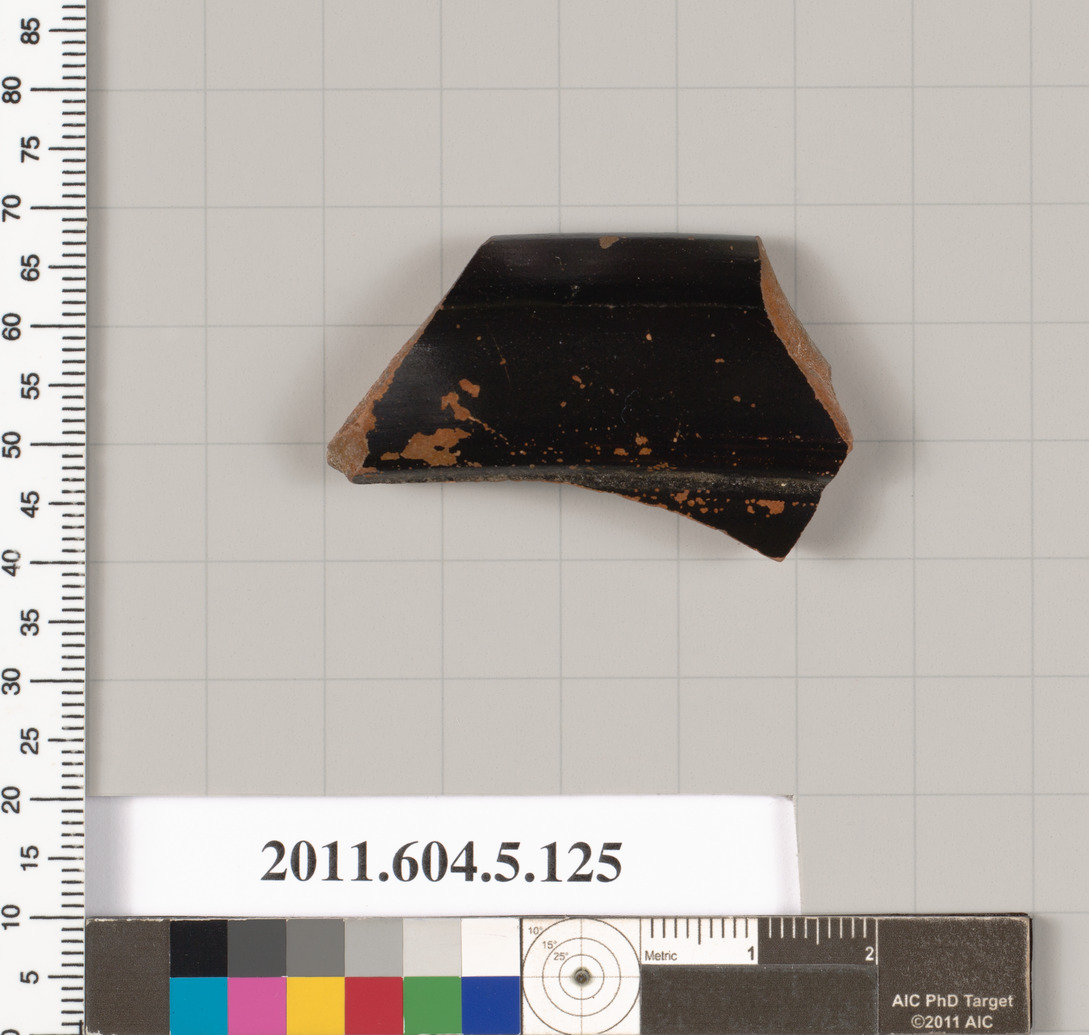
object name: kylix fragment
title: Terracotta rim fragment of a stemless kylix (drinking cup)?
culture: greek, attic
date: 470-450 BCE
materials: terracotta